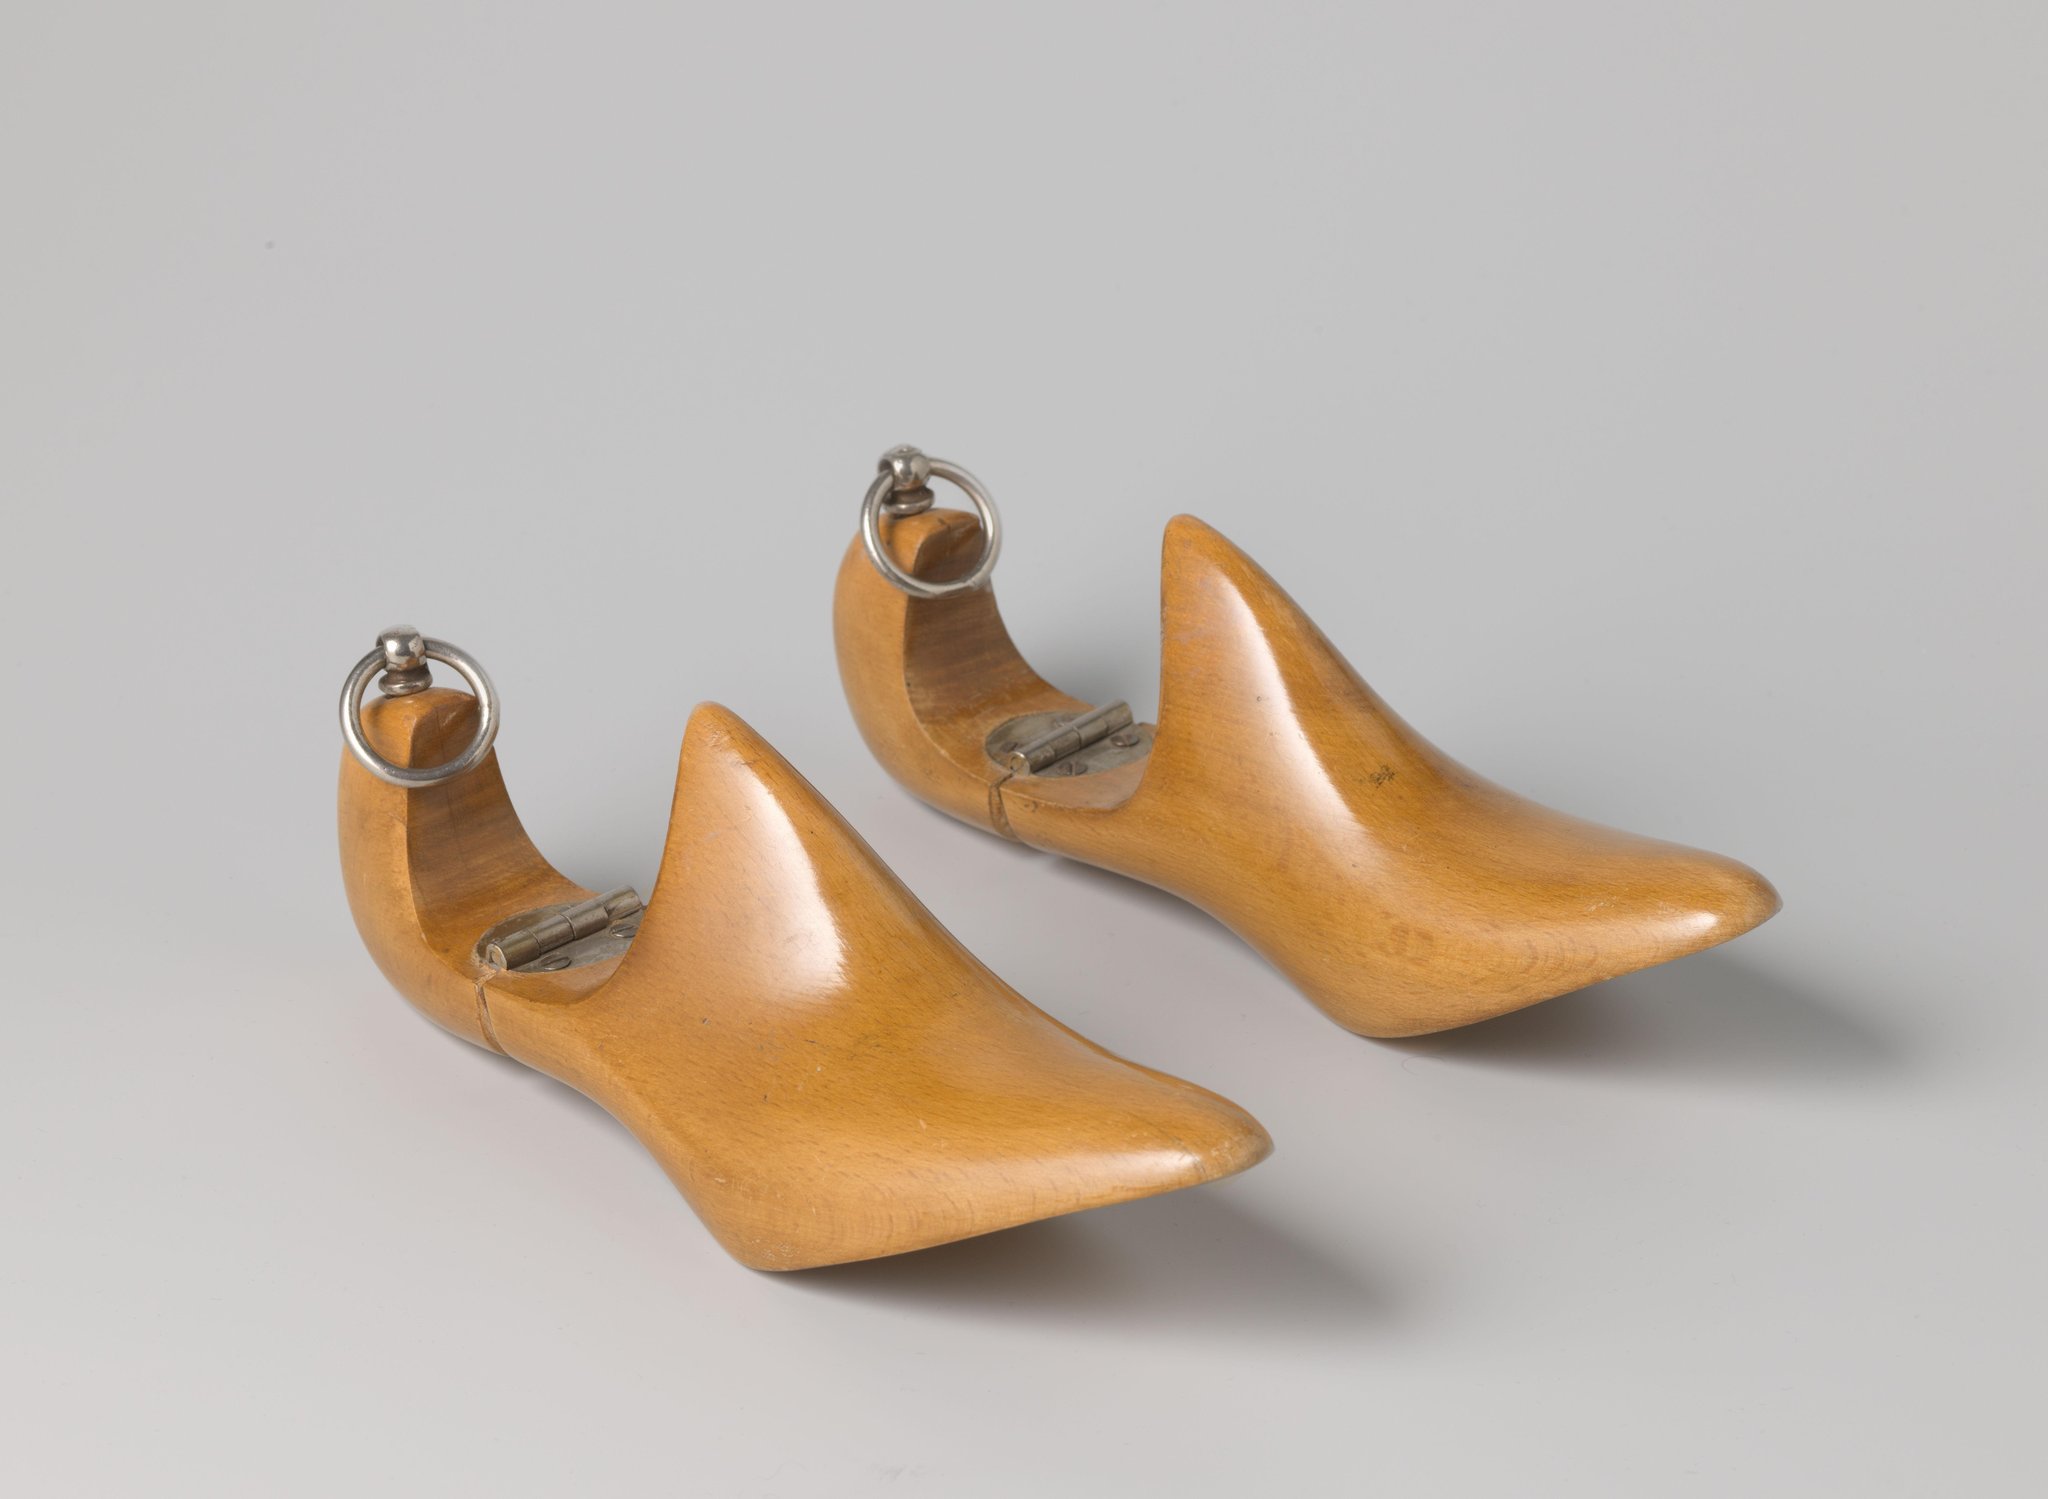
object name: boot tree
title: Spanleest behorend bij bandschoen van krokodillenleer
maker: a. van goethem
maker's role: schoenmaker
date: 1939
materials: metal, wood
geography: brussels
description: Linker spanleest, deel van een paar, van hout met metalen scharnier en ring. Behorend bij bandschoen van blauwzwart krokodillenleer. Adres: VAN GOETHEM/BOTTIER/BRUXELLES (op metalen plaatje).